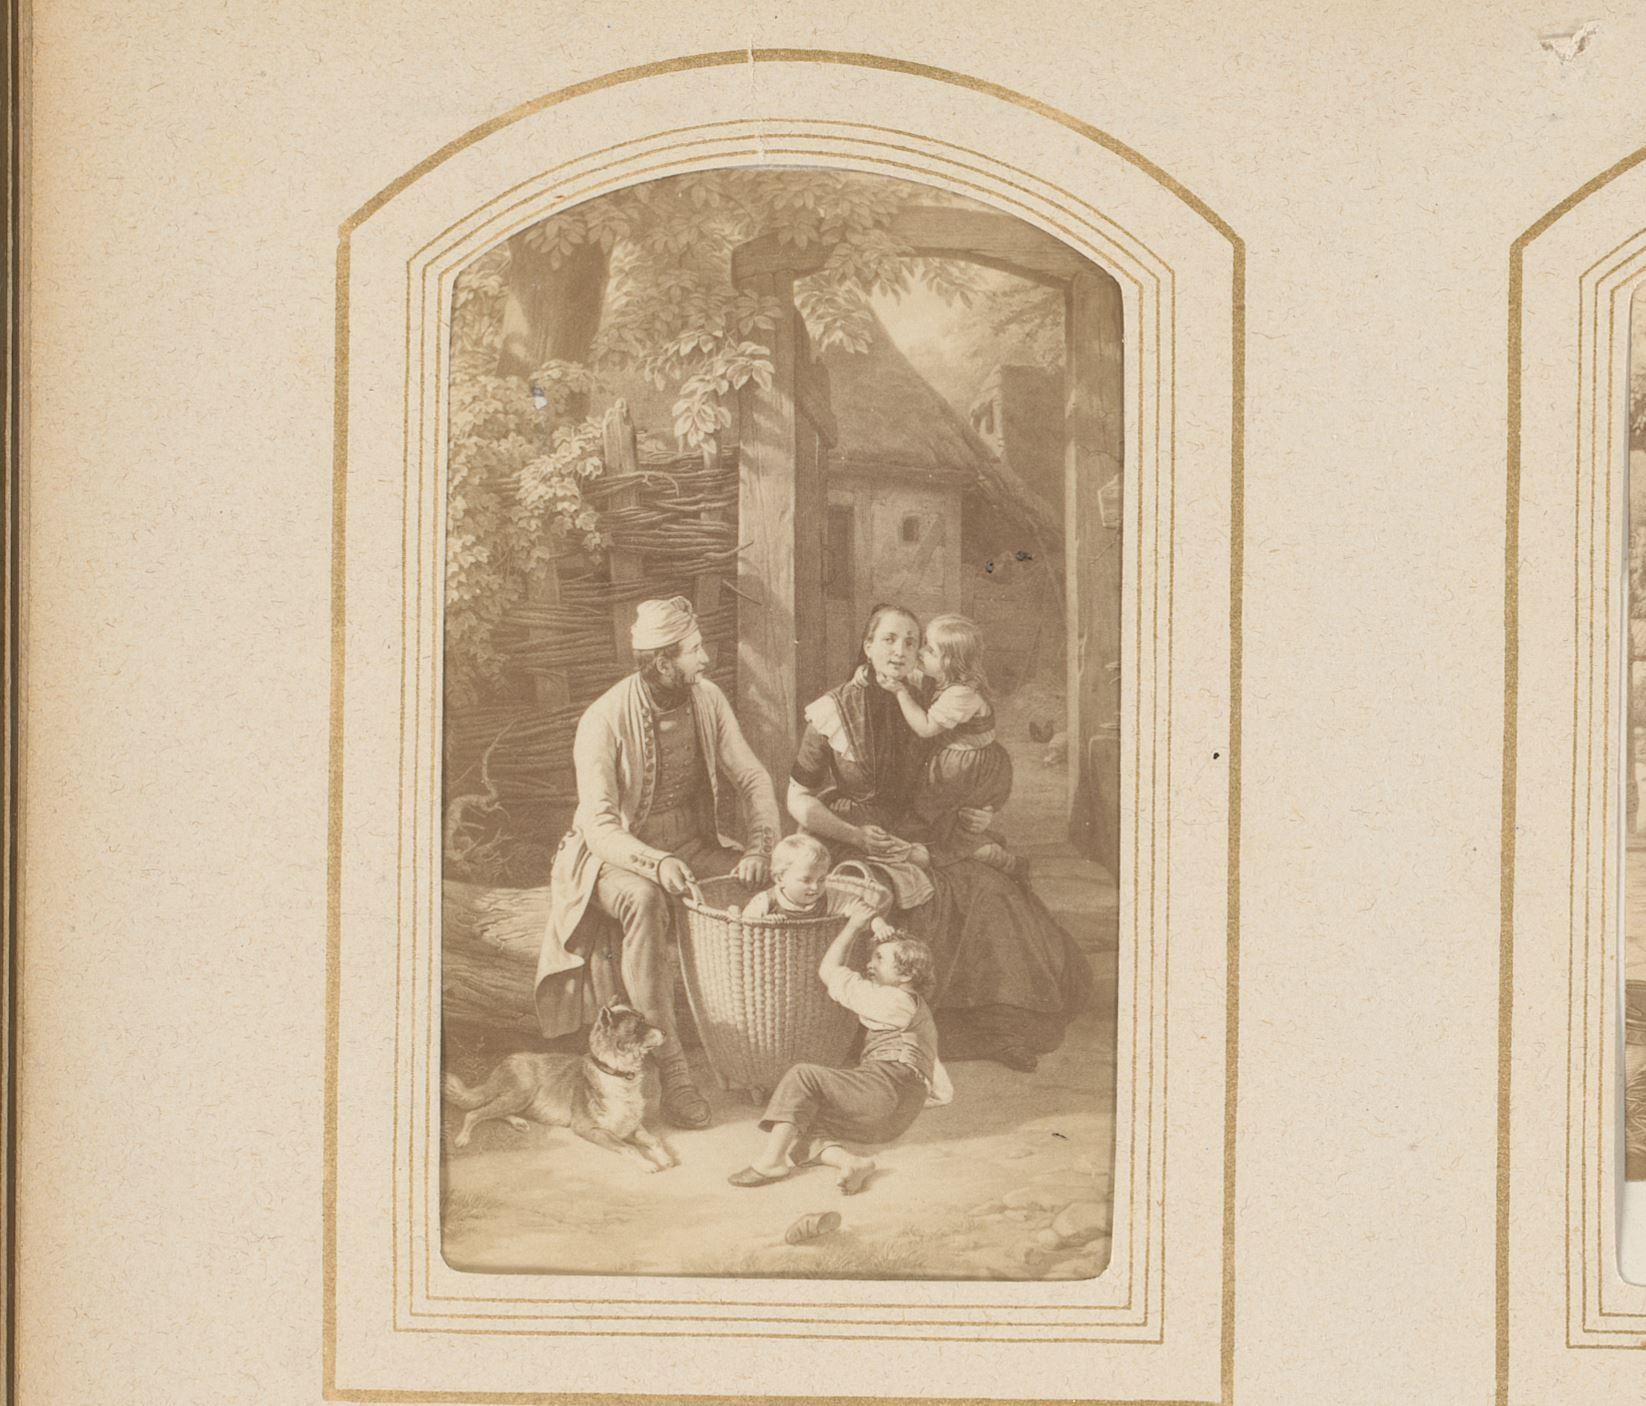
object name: album leaf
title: Fotoreproductie van Die Feierstunde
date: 1870-1890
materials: cardboard, photographic support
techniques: albumen print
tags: parents with their children, container made of plant material other than wood: basket, dog, painting, drawing and the graphic arts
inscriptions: annotation: ‘Die Feierstunde’, number: ‘1’